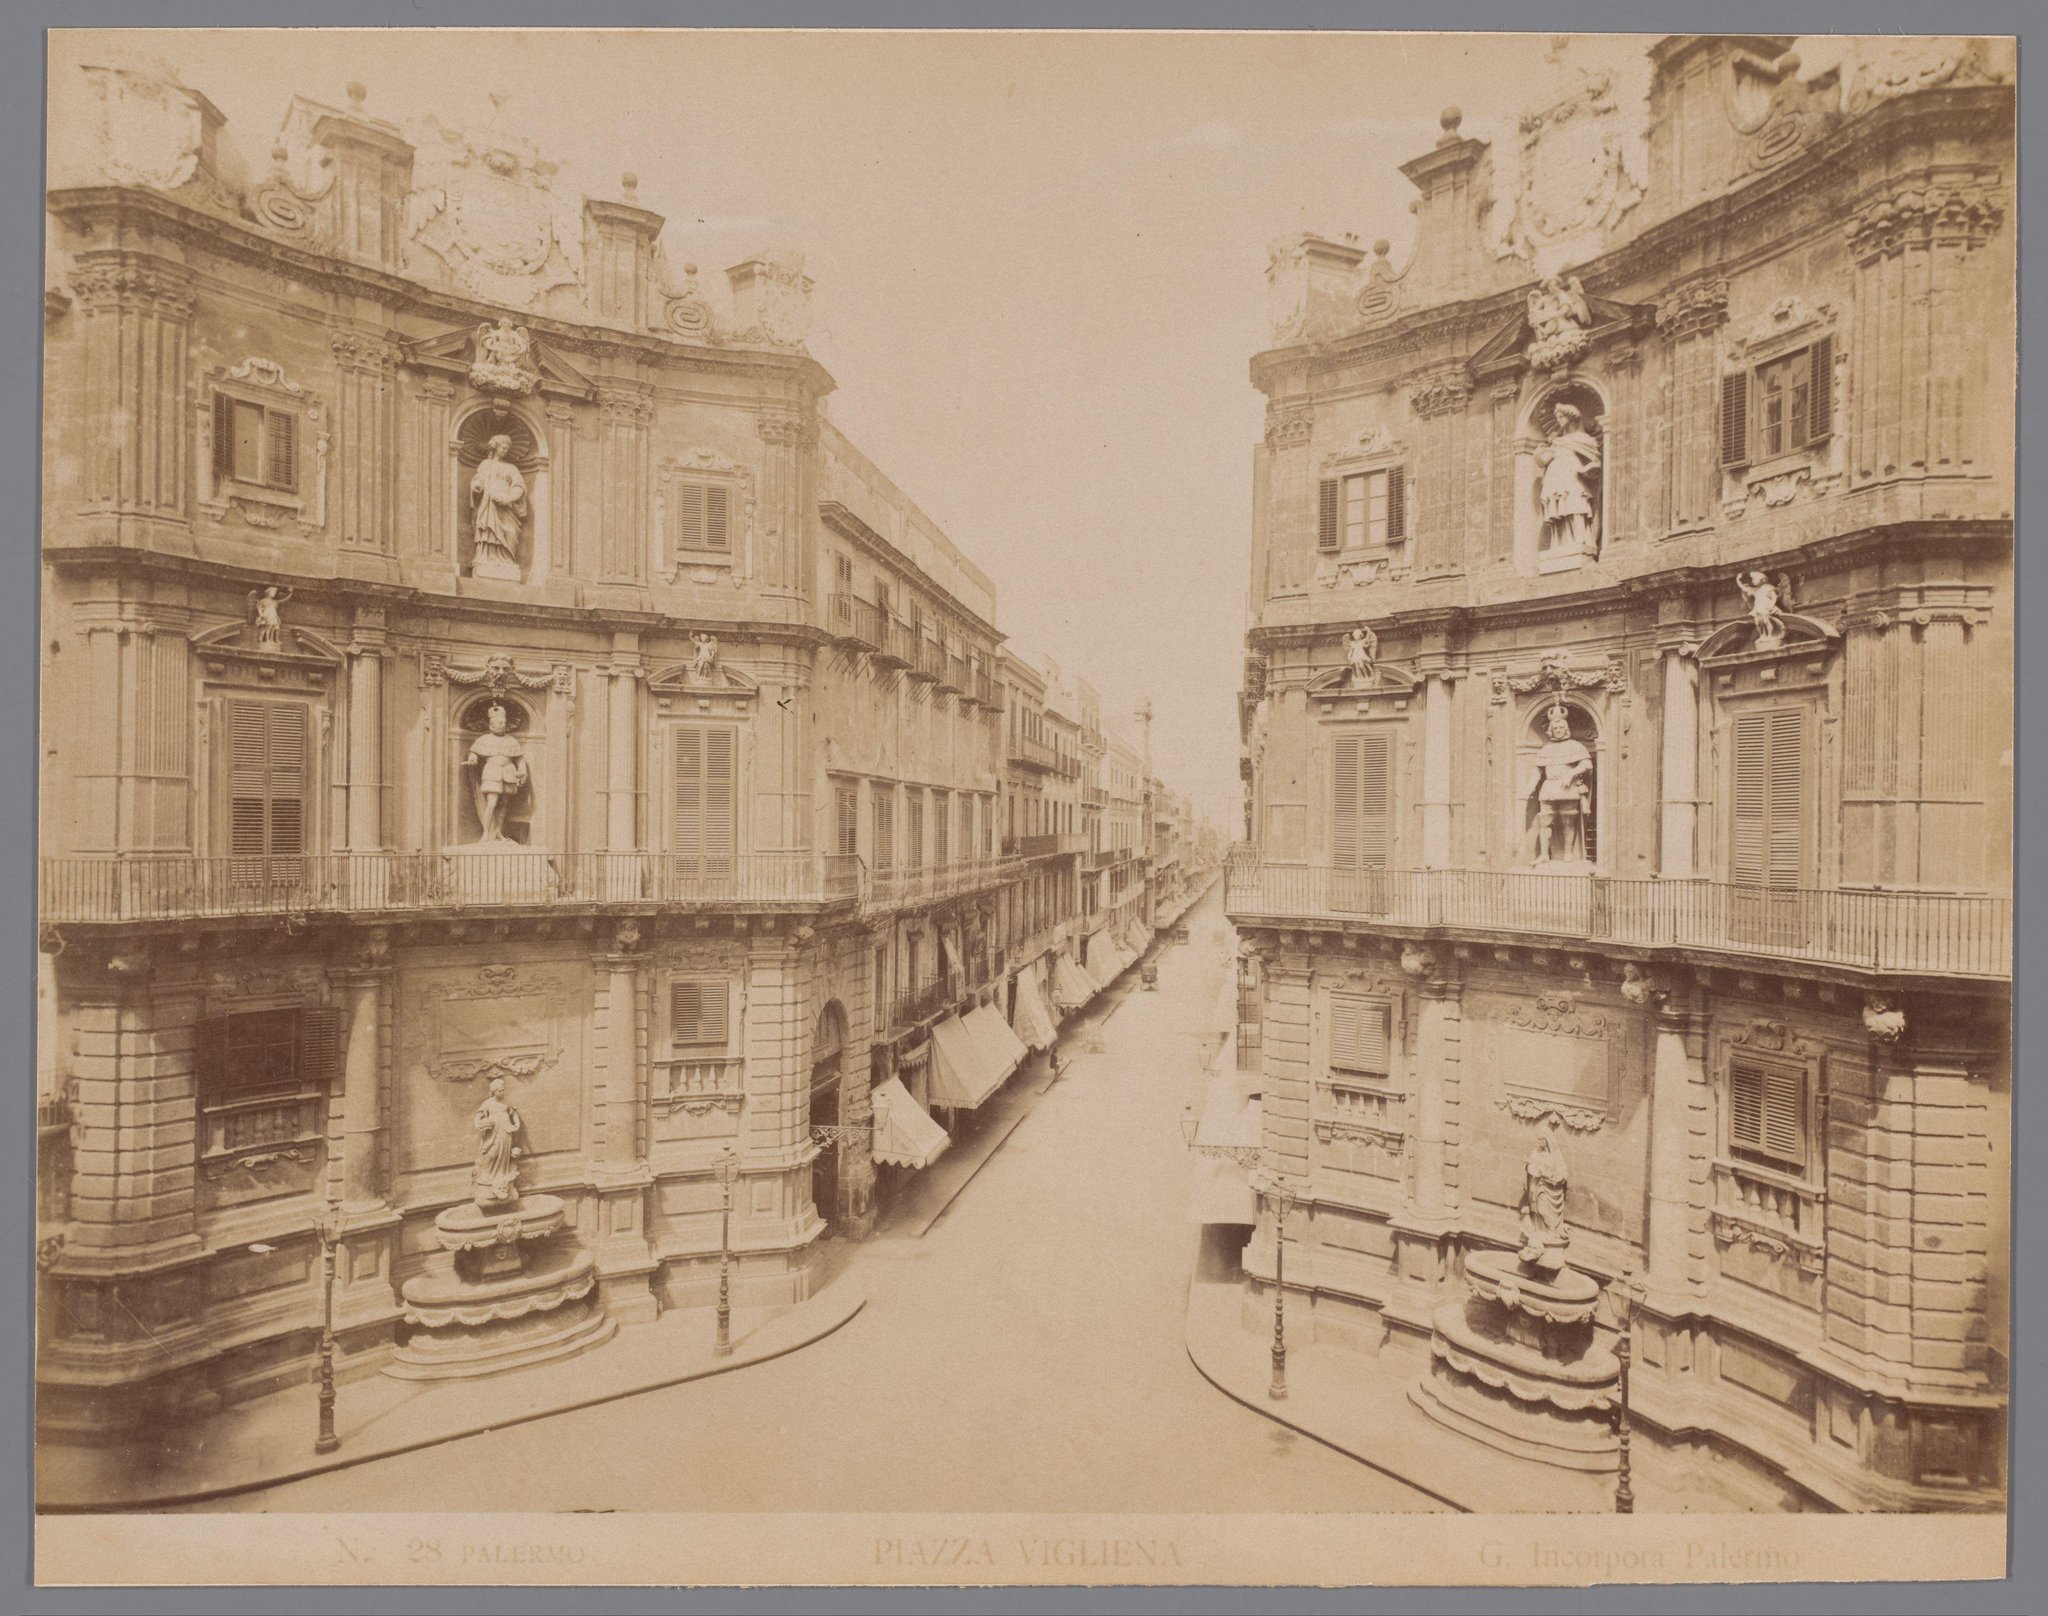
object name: photograph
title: Gezicht vanaf het Piazza Vigliena op de Via Toledo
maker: giuseppe incorpora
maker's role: fotograaf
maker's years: 1834-1914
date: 1856-1914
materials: cardboard, paper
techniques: albumen print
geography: palermo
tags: square, place, circus, etc.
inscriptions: number: ‘N. 28’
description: Via Toledo heet tegenwoordig Corso Vittorio Emanuele.